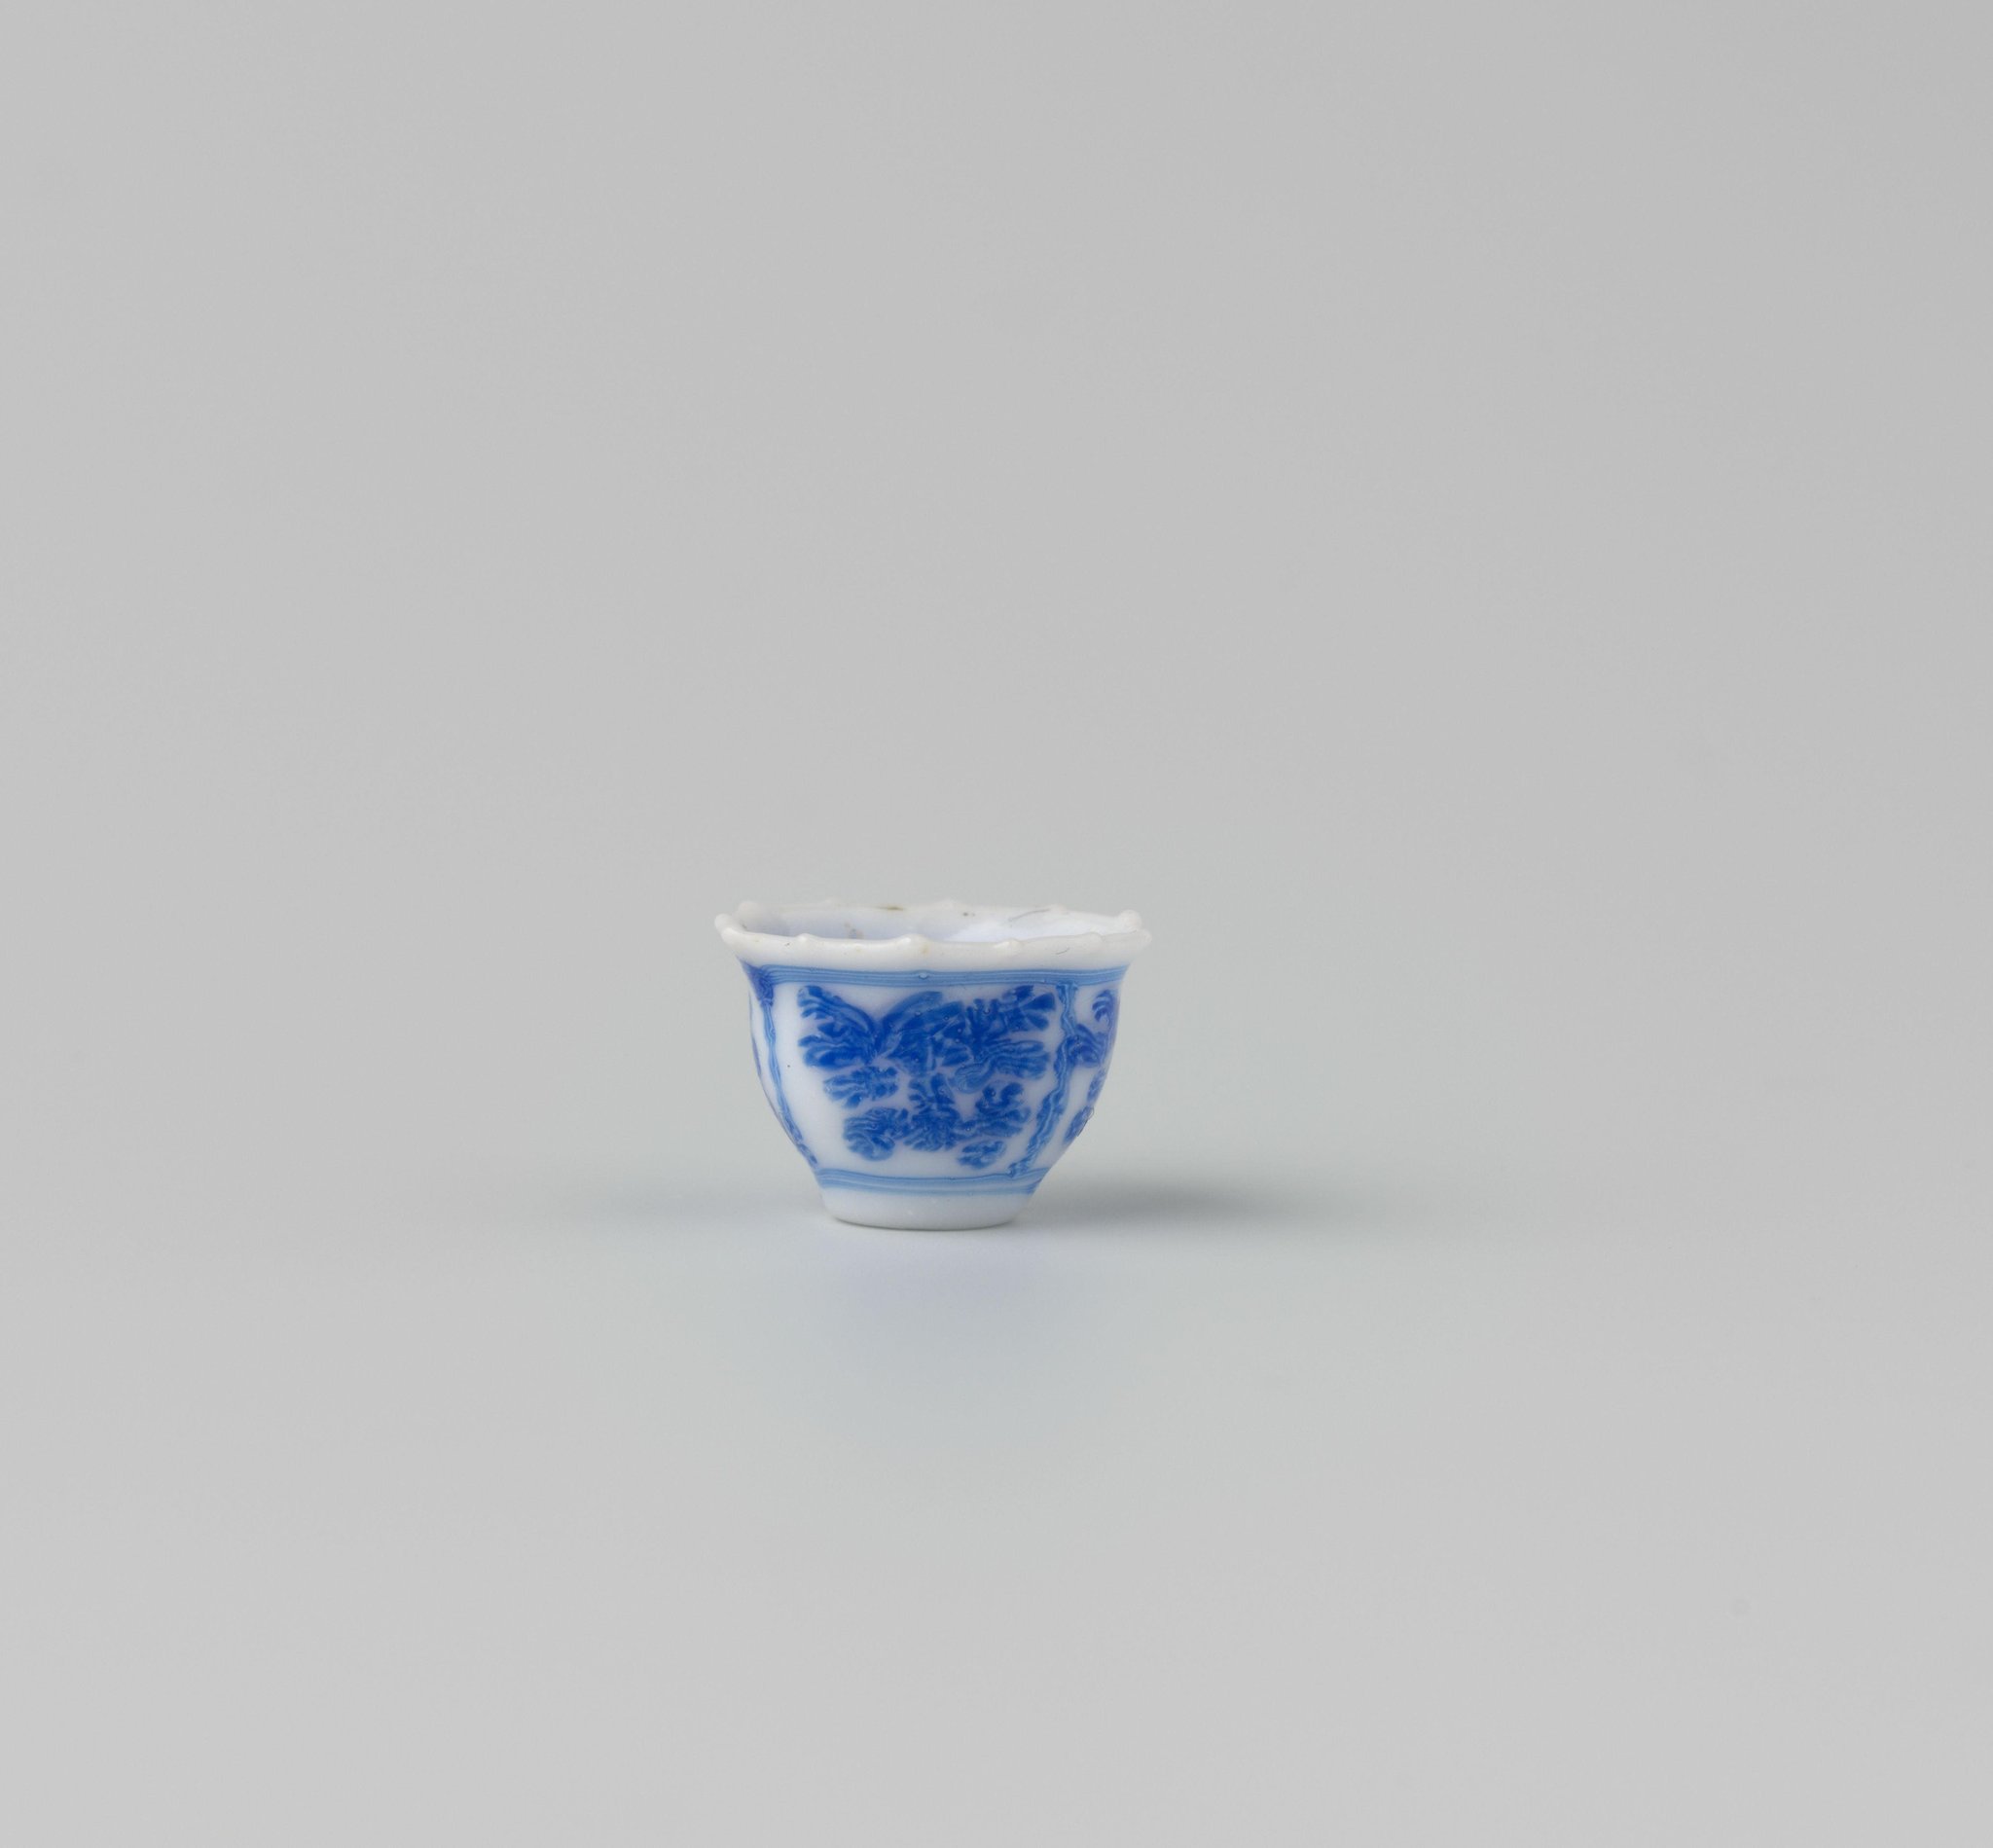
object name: tea cup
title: Theekopje van melkglas met blauwe emailverf beschildering, imitatie Chinees porselein met 'bloem' decoratie in drie vakken; model met puntrand, nauwelijks een standring.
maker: Anonymous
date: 1675-1710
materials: glass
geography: amsterdam